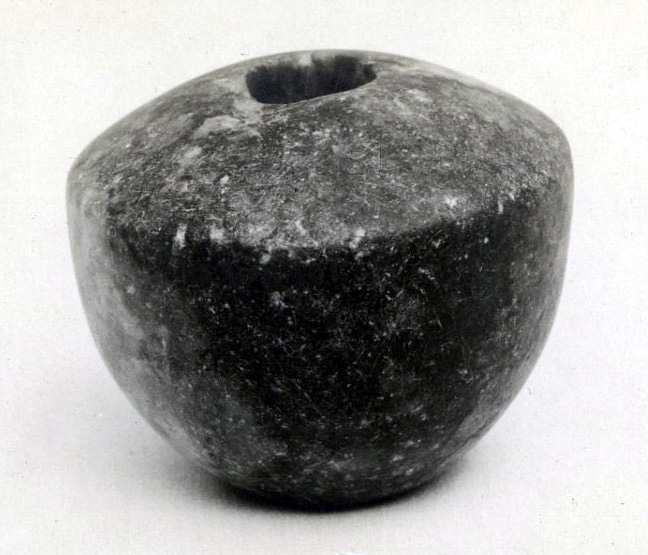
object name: mace head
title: Macehead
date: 3850-2960 BCE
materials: stone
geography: egypt